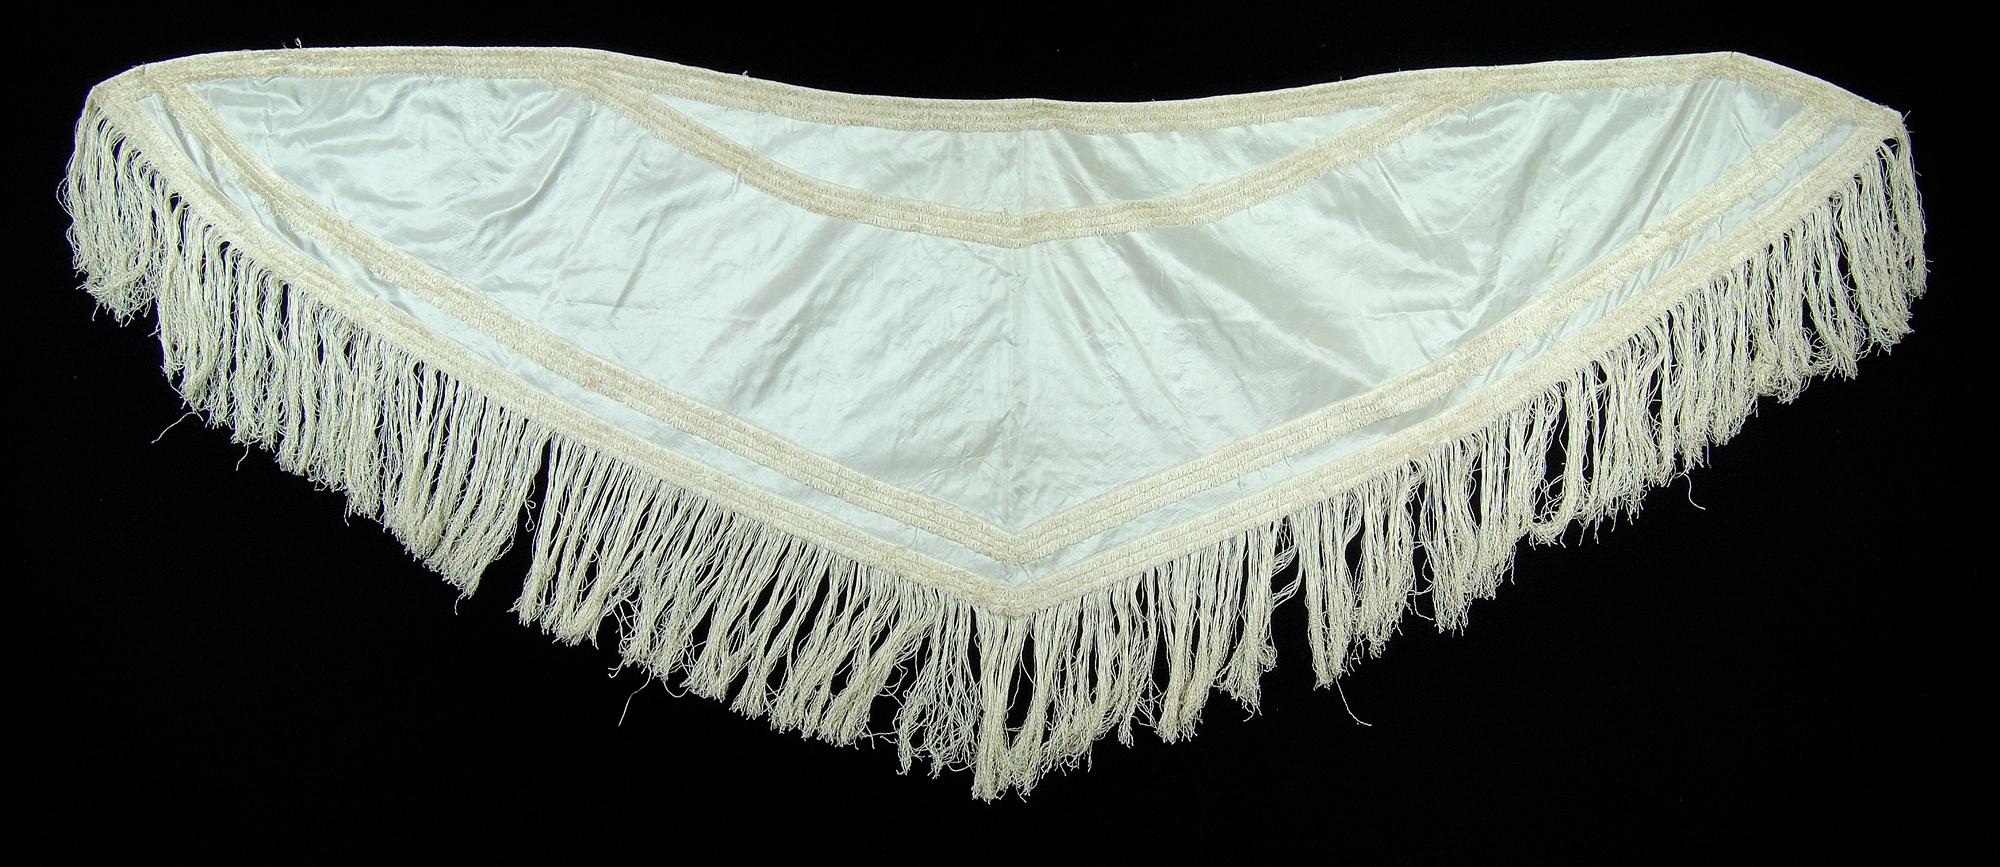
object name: pelerine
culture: american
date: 1875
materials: silk